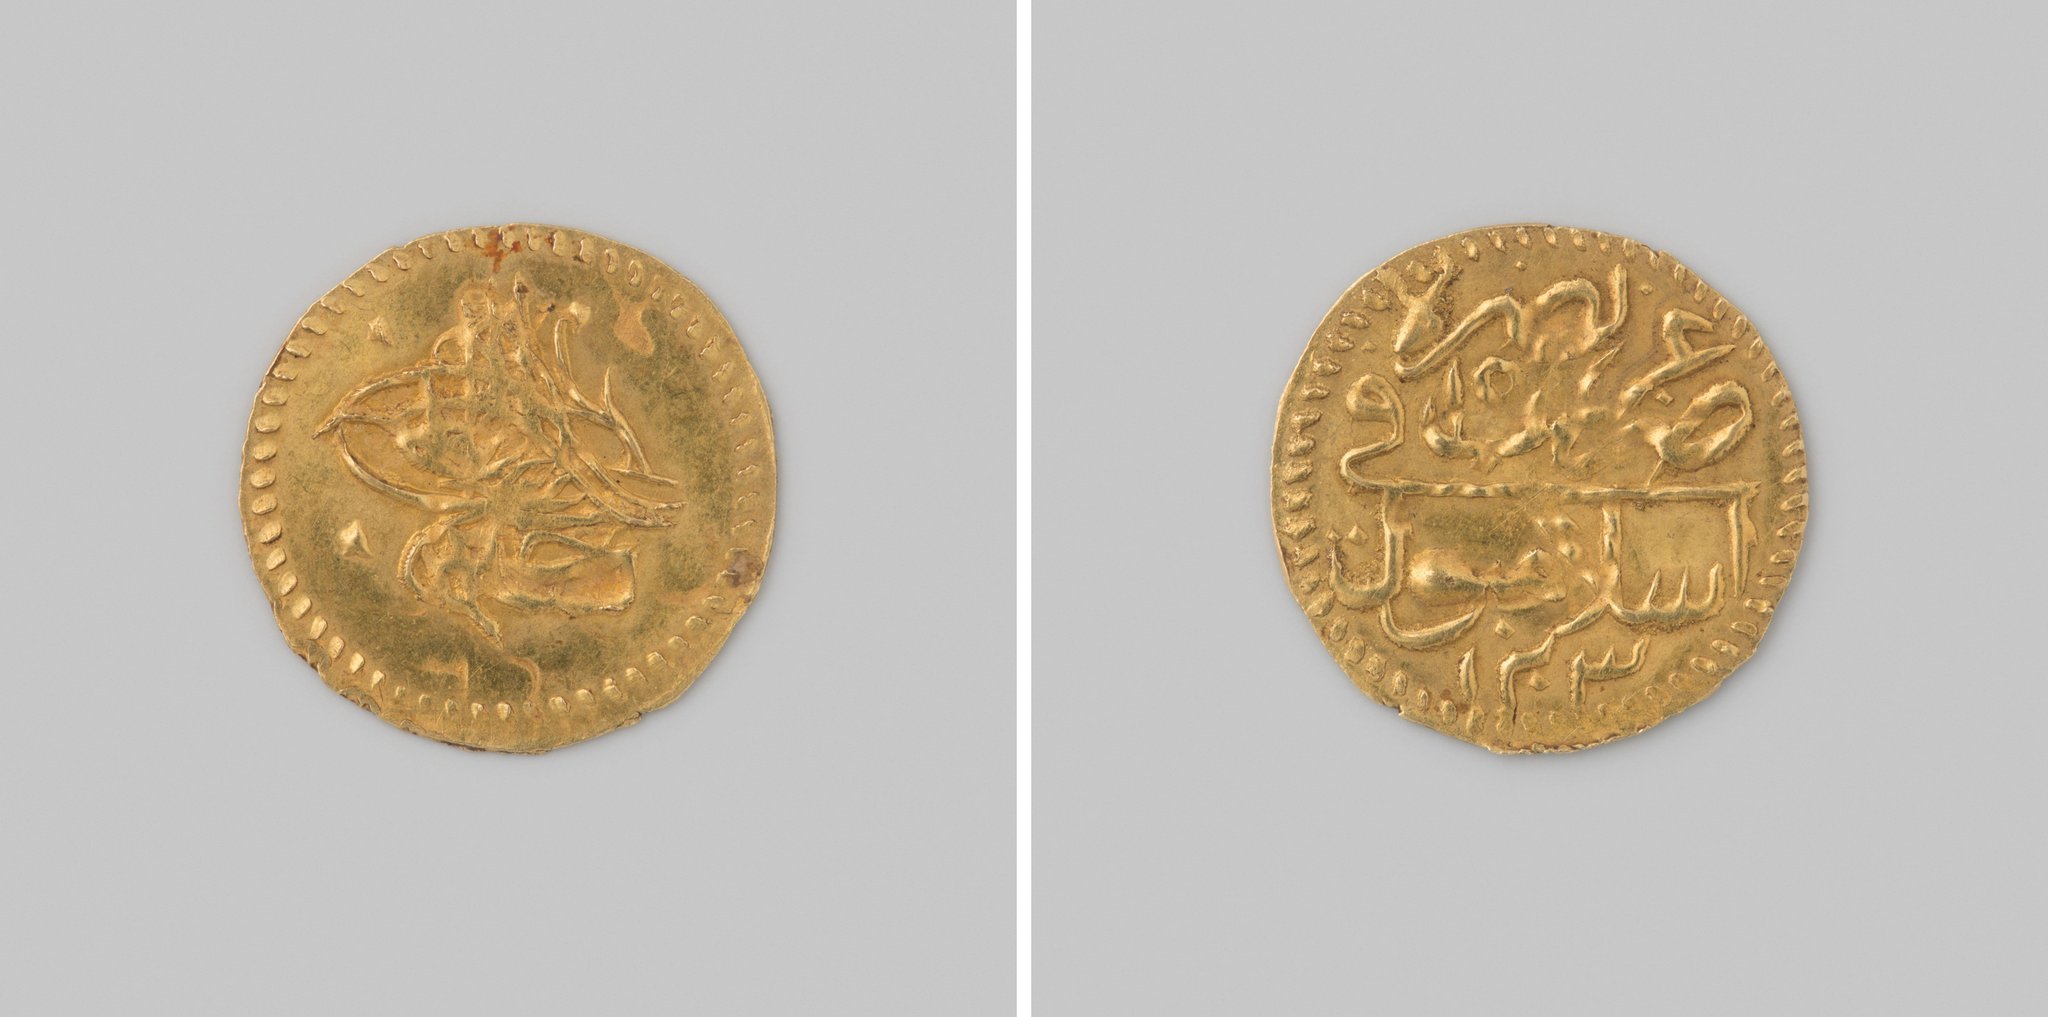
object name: coin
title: 1/4 altin of 1/4 zeri mahbub uit Turkije van sultan Selim III, regeringsjaar 15 [=1803]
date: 1803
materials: gold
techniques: striking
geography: istanbul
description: Gouden munt. Voorzijde: tughra, met rechts daarvan takje. Onder de tughra opschrift in Arabische letters. Keerzijde: vierregelig opschrift in Arabische letters met muntplaats-aanduiding: Islambul. Boven in opschrift regeringsjaar: 15. Onderaan jaar van aantreden:1203 [=1789].